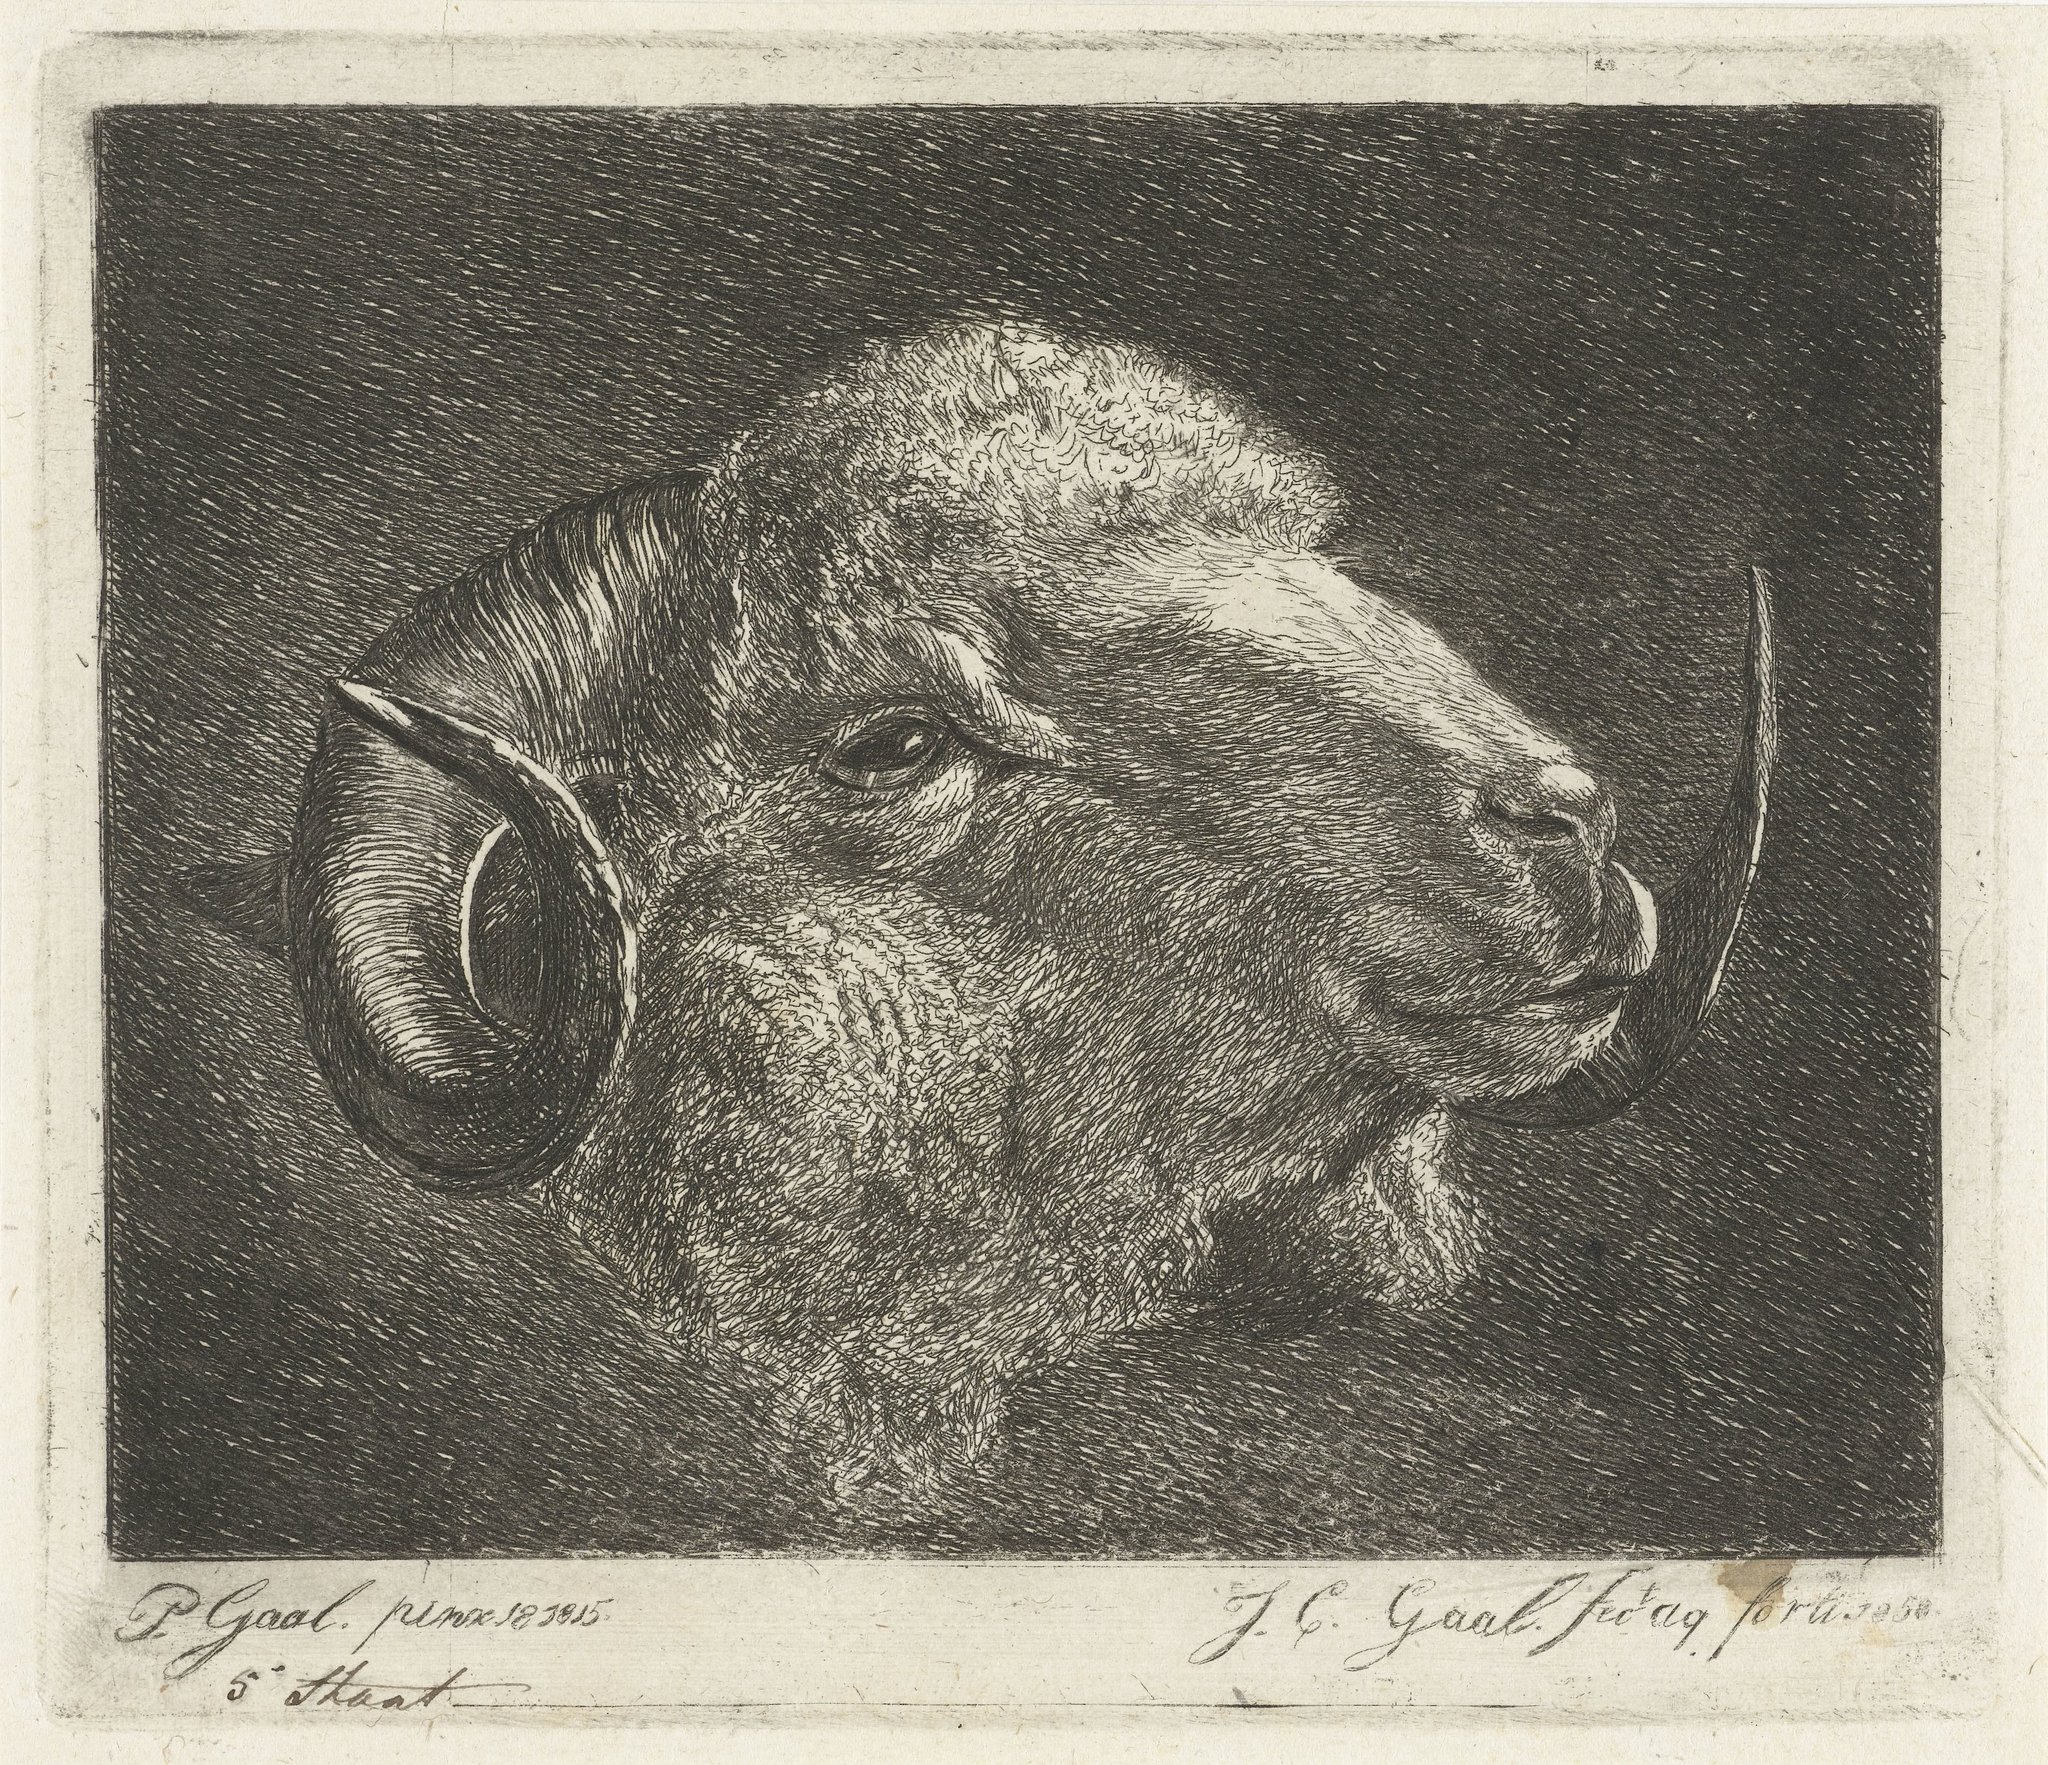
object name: print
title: Kop van een ram met naar achteren gedraaide hoorns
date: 1858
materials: paper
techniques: etching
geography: netherlands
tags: ram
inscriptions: collector's mark: Lugt 2228